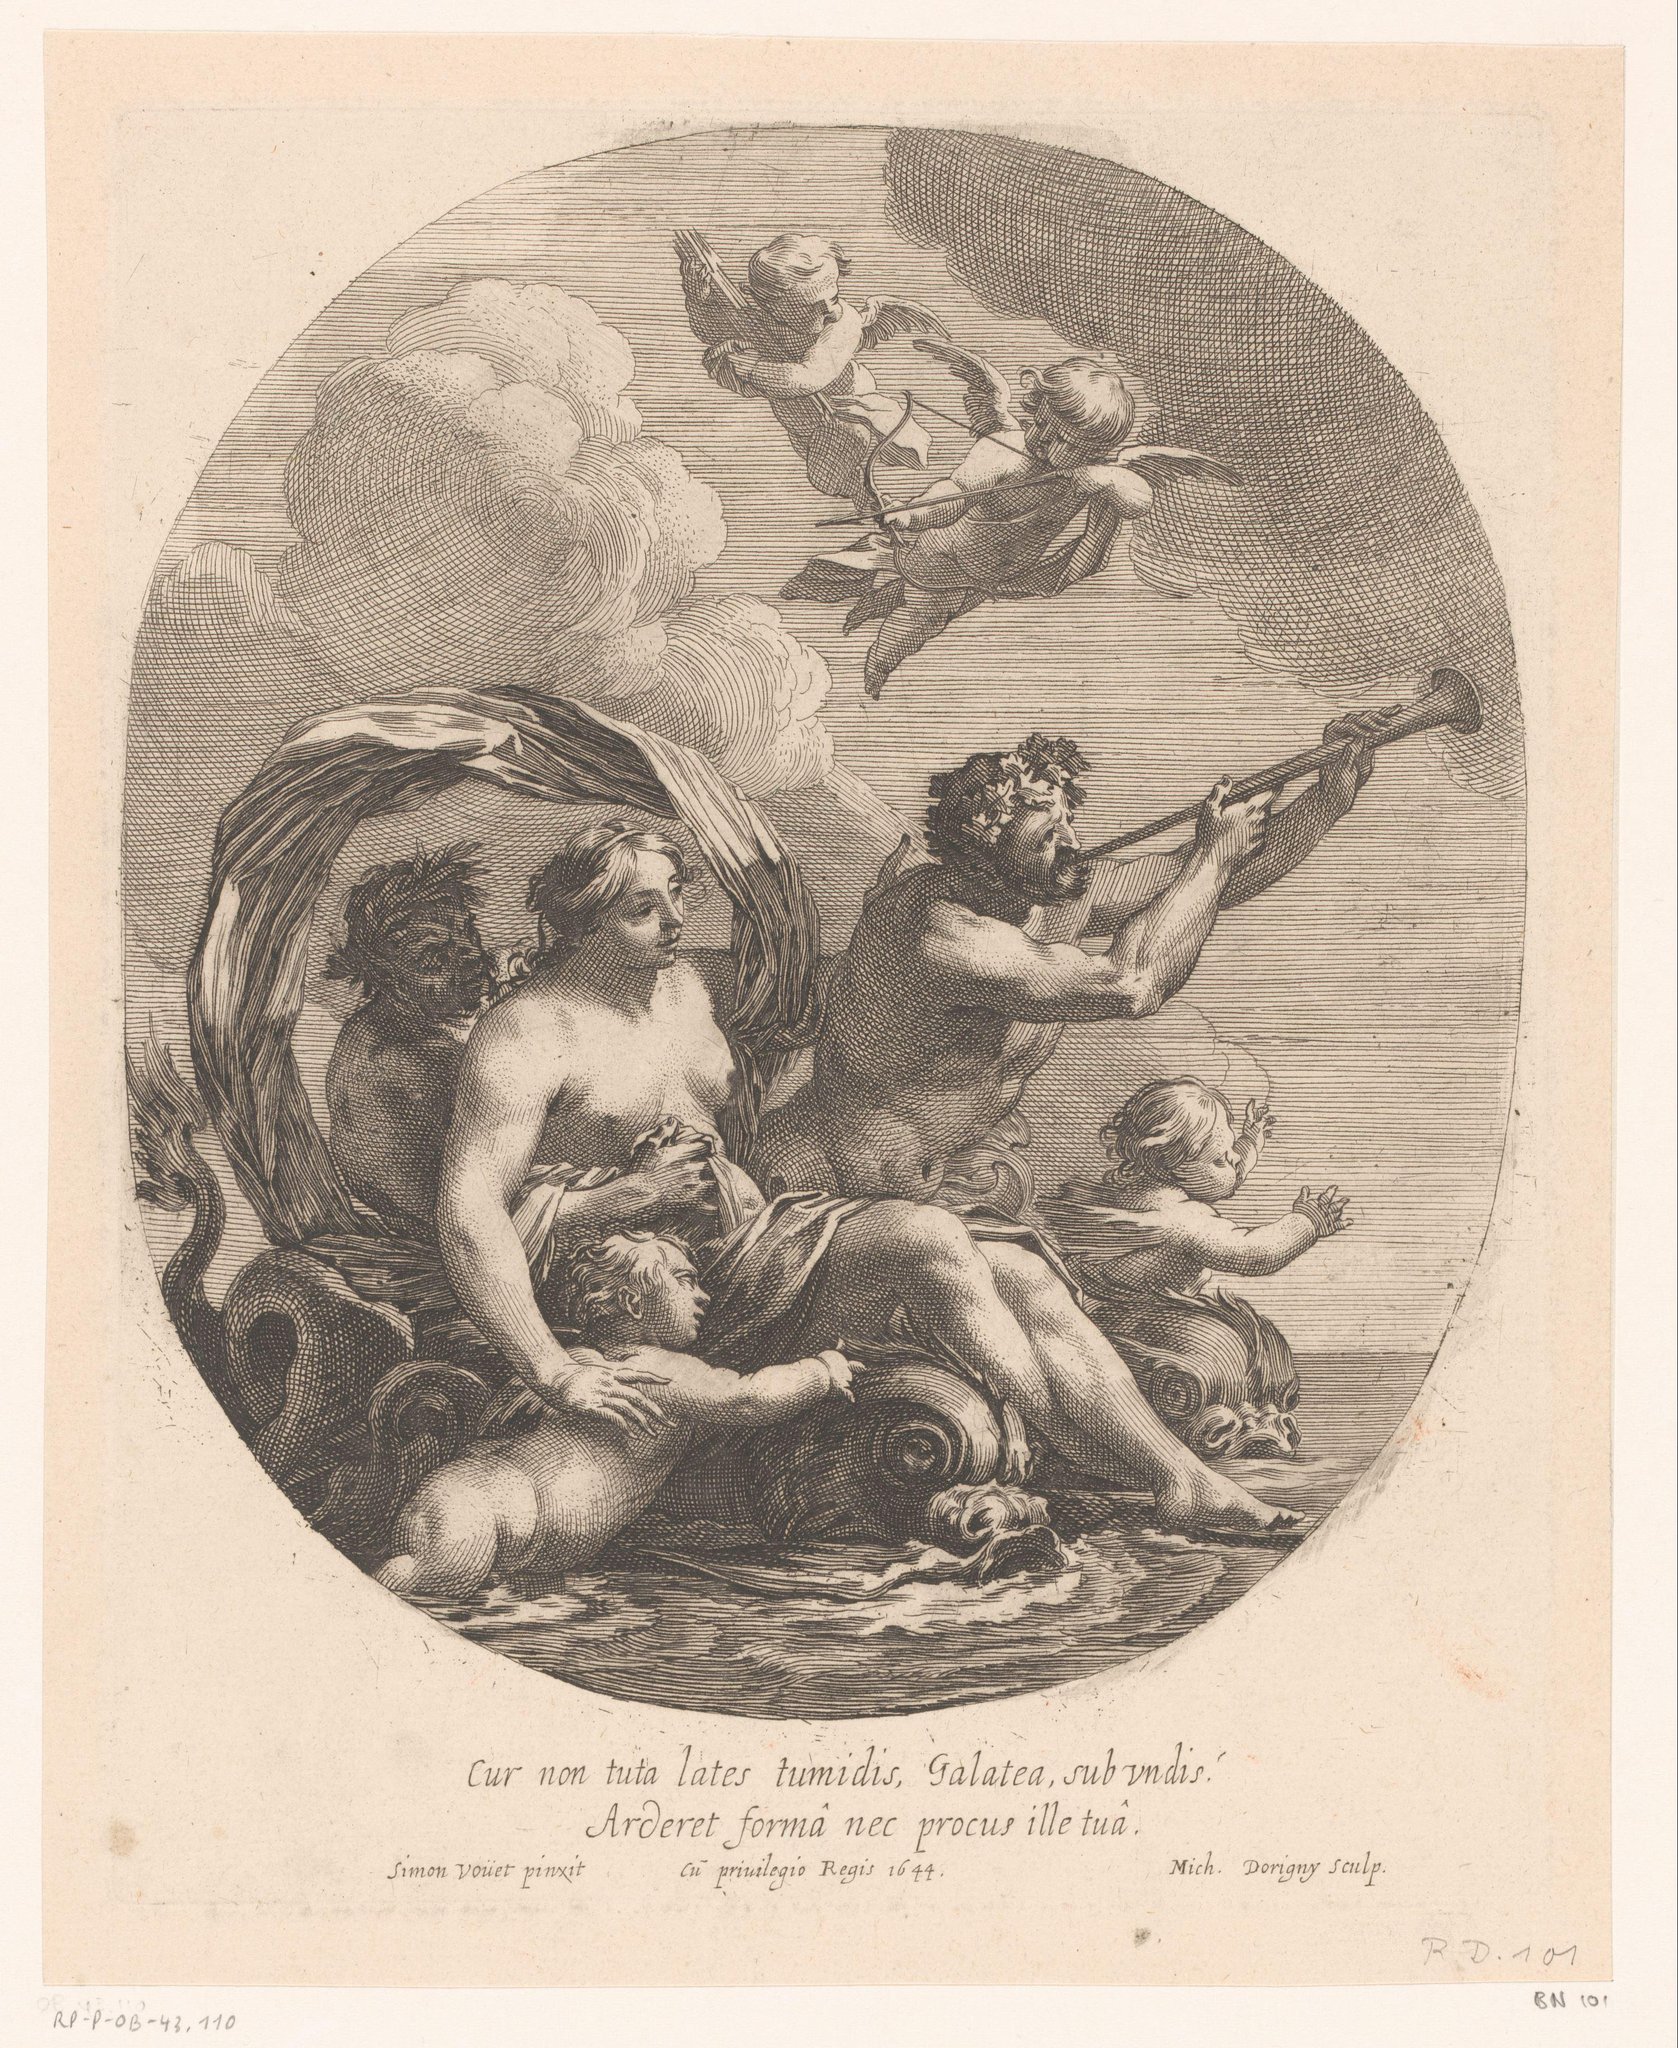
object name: print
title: Triomf van Galatea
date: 1644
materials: paper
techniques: engraving, etching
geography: france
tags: triumph of galatea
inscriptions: collector's mark: Lugt 2228